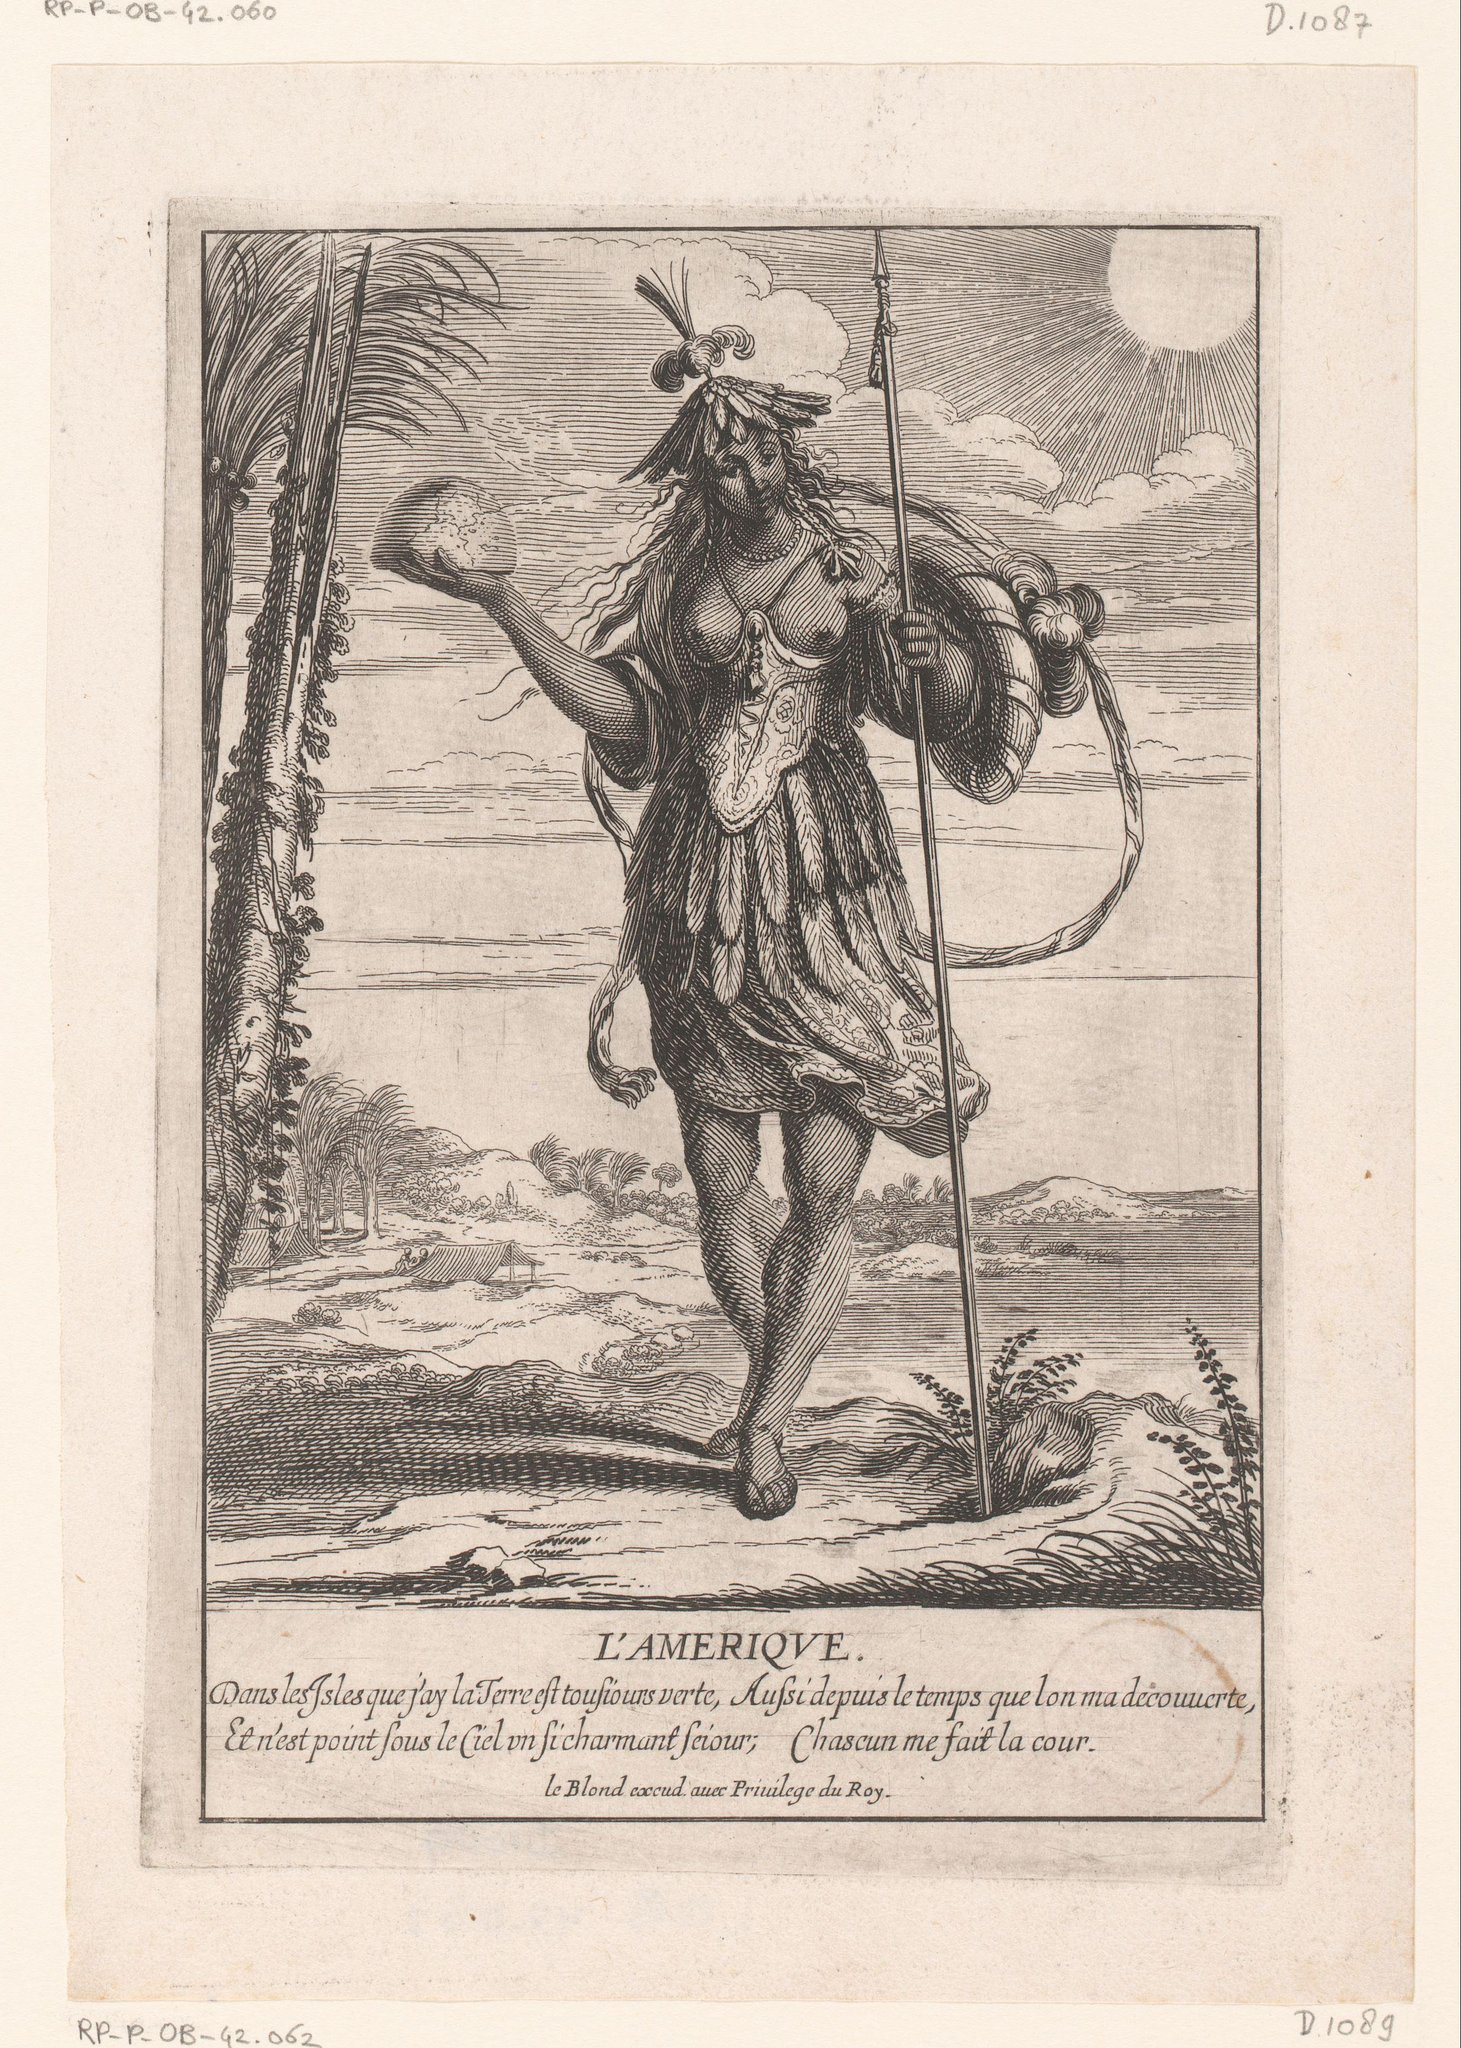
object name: print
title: Amerika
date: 1612-1666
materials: paper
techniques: engraving, etching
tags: america represented allegorically; 'america' (ripa), continents represented allegorically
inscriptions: collector's mark: Lugt 240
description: Maakt deel uit van een vierdelige serie met personificaties van de vier continenten.